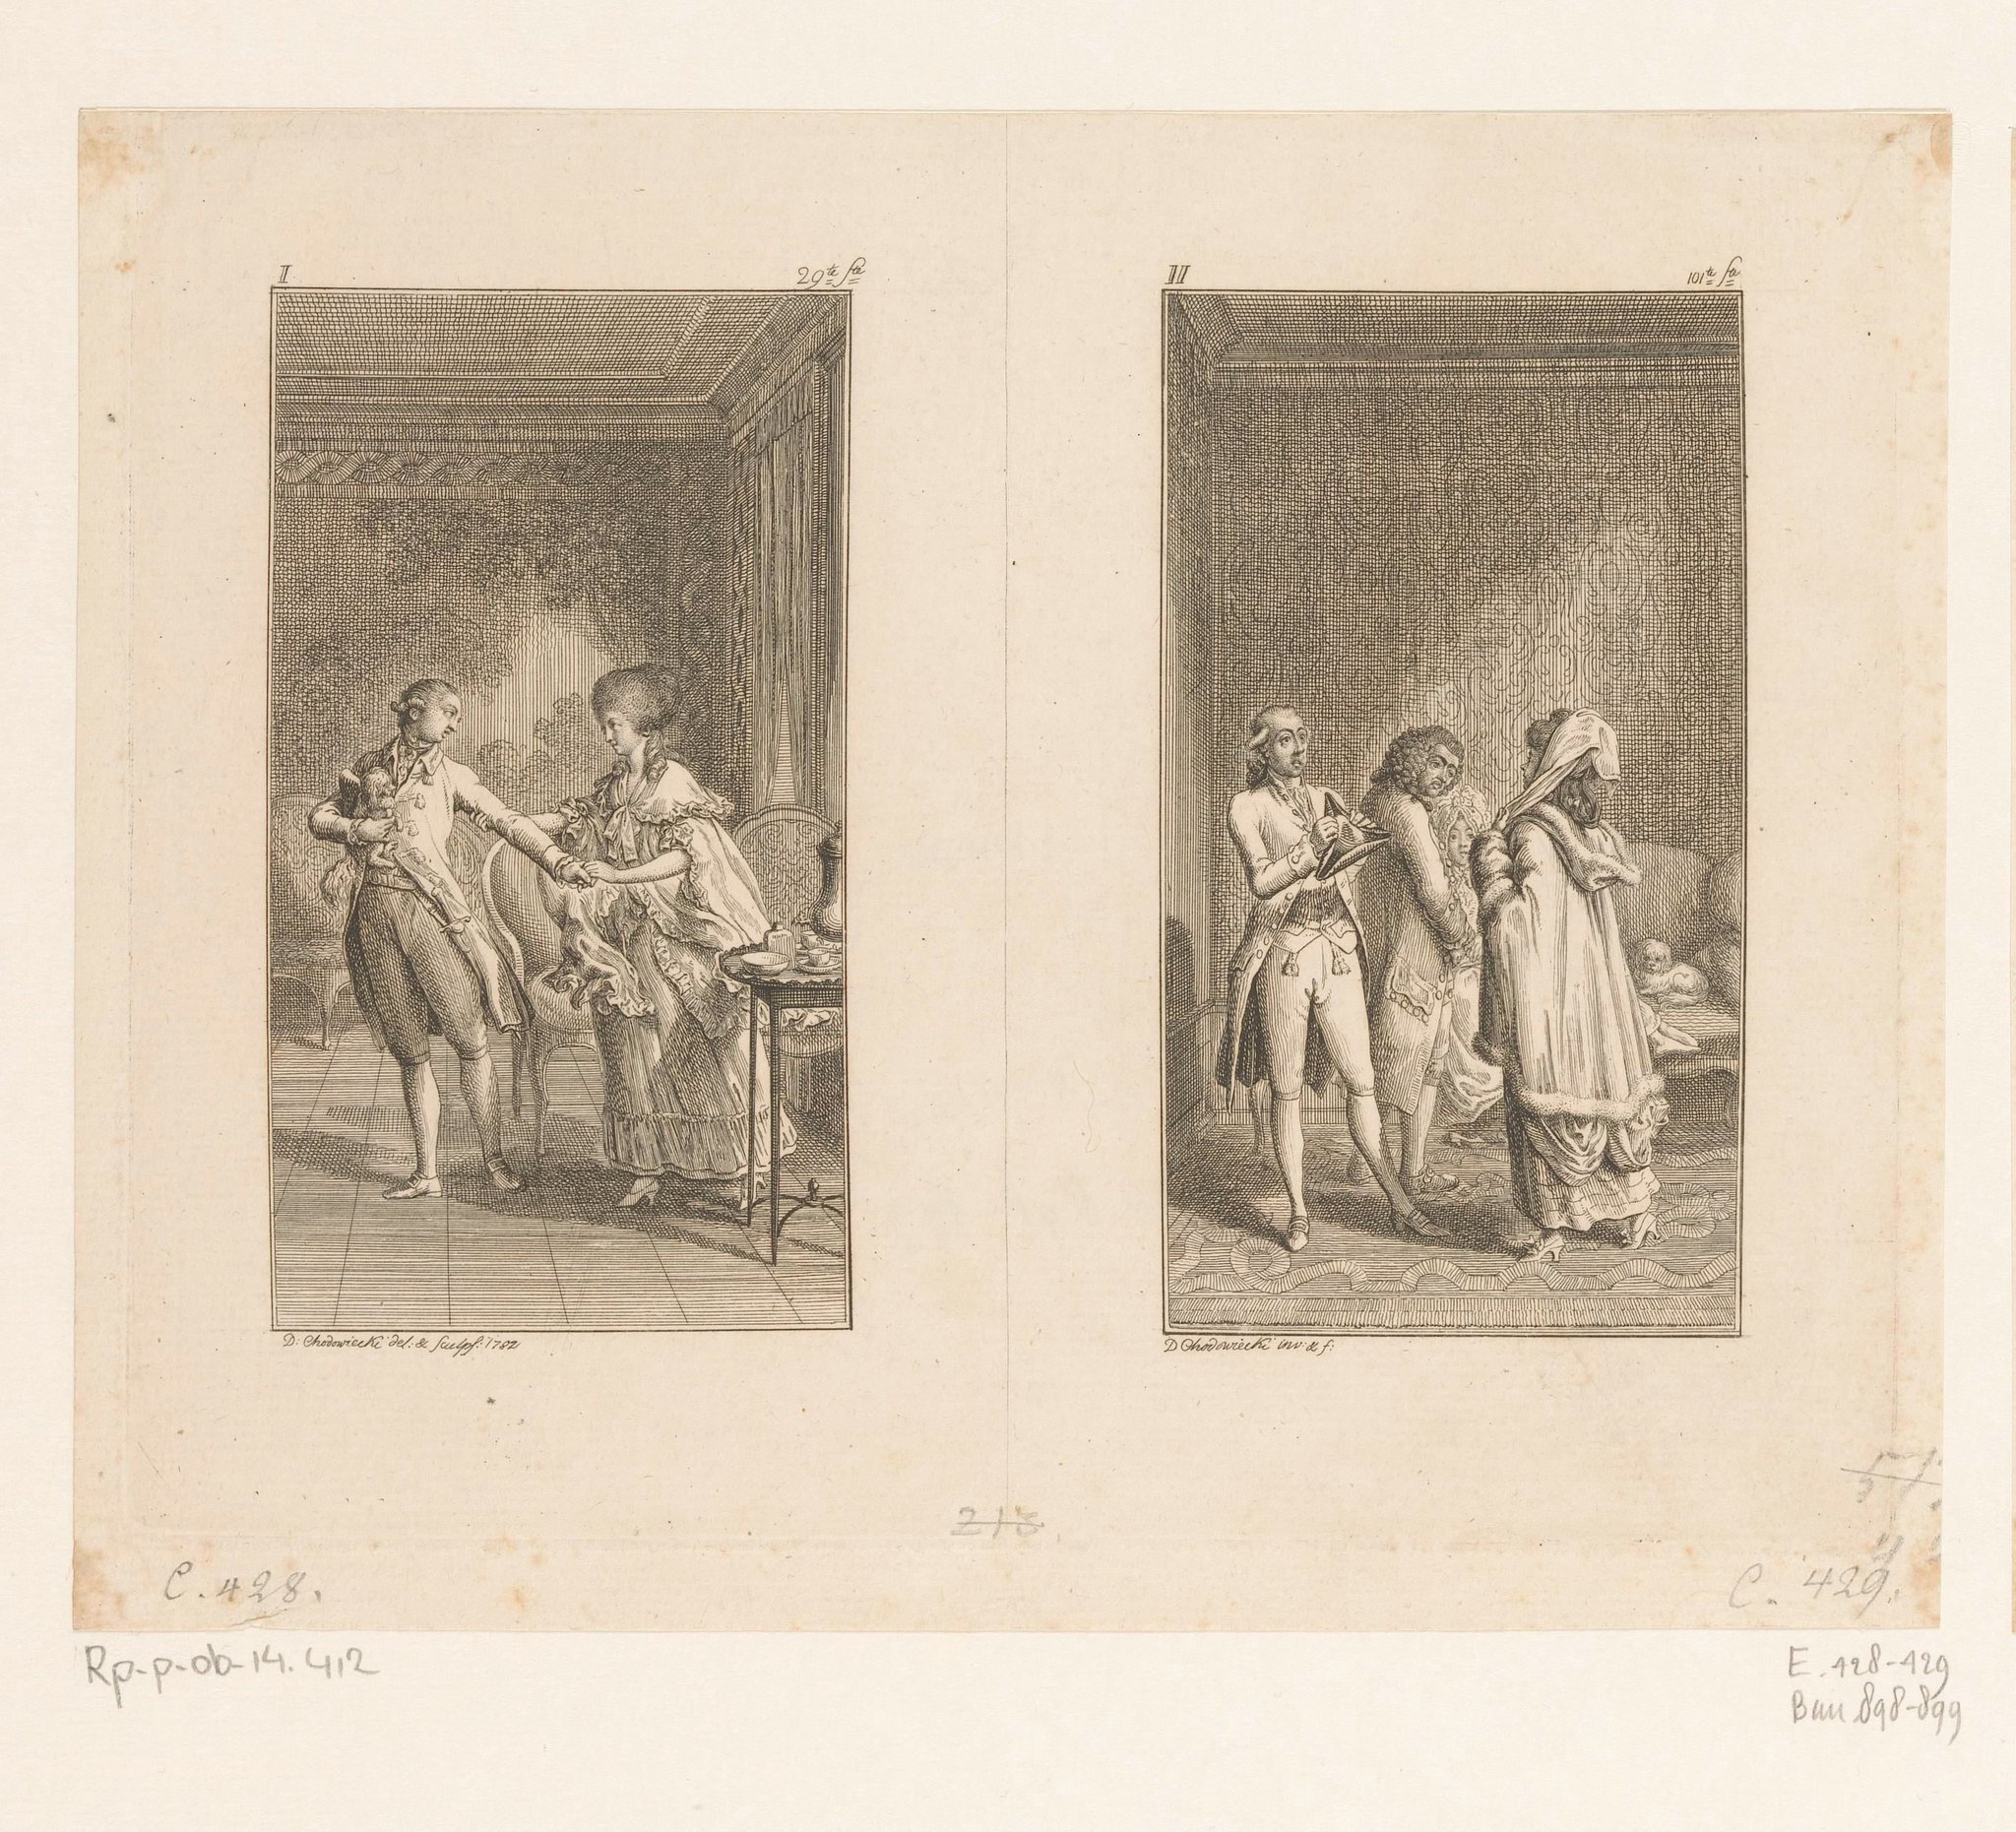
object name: print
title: Twee voorstellingen uit Der kleiner Cäsar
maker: daniel nikolaus chodowiecki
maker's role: draughtsman, print maker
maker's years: 1726-1801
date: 1782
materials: paper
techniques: etching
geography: berlin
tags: parting, leave-taking (of lovers), gripping someone by the hand or the wrist; clasped hands, dog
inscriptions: collector's mark: Lugt 2228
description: Prent gebruikt voor: Coventry, Francis. Der kleine Cäsar (...). 2 dln. Leipzig: Dykischen Buchhandlung, 1782, dl. 1.